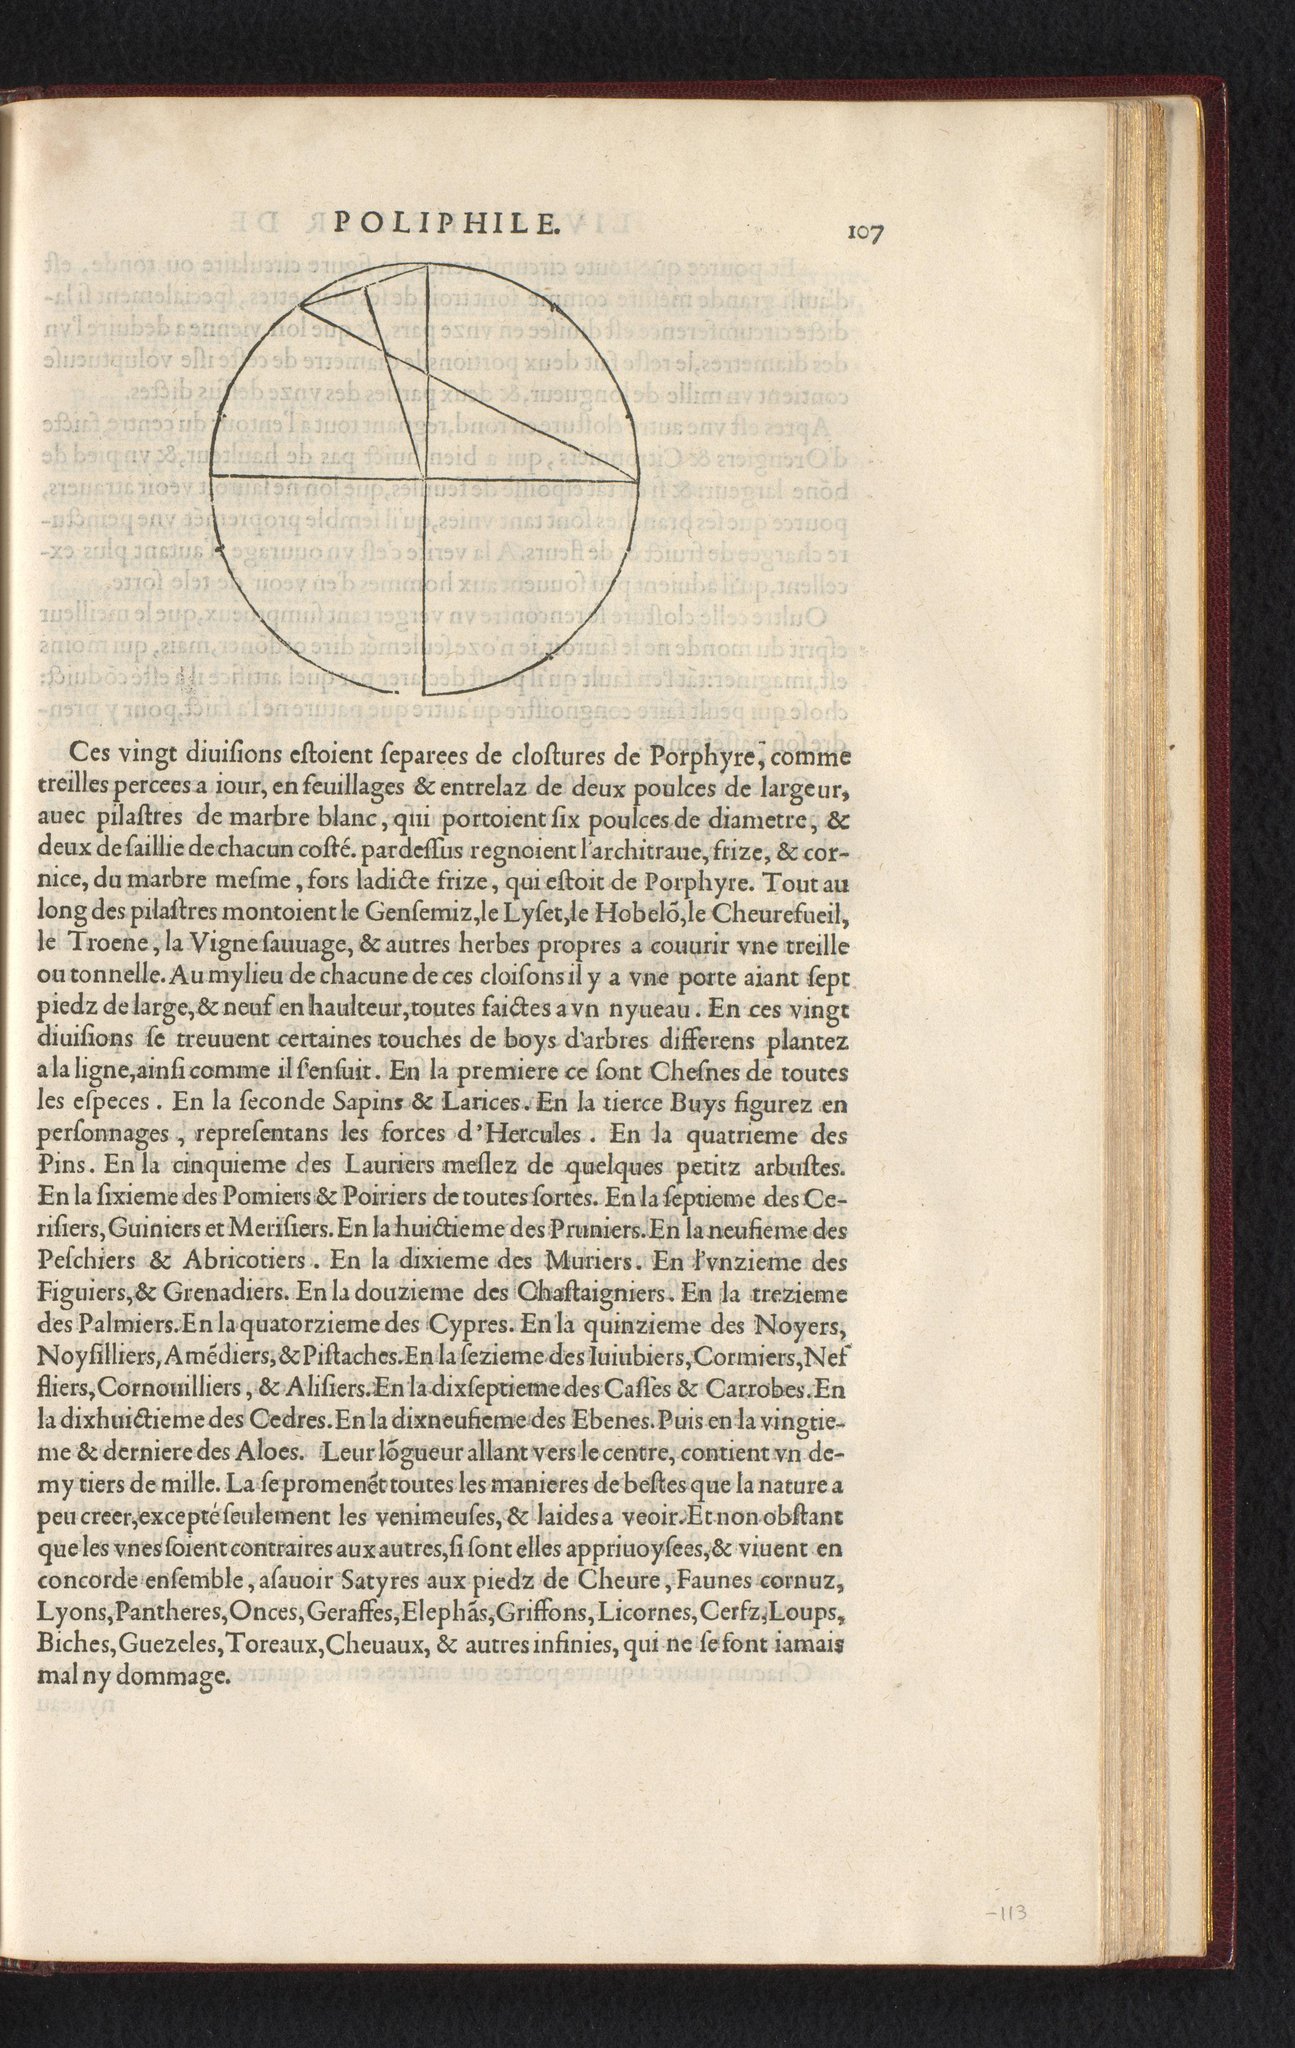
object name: print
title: Wiskundige verdeling van een cirkel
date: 1546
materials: paper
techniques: letterpress printing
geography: paris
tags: (scenes from) specific works of literature: colonna, hypnerotomachia poliphili, circle (~ planimetry, geometry)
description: Prent uit: Colonna, Francesco. Hypnerotomachie ou discours du songe de Poliphile, deduisant comme amour le combat a l'occasion de Polia. Parijs: Jacques Kerver, 1546, recto fol. 107.